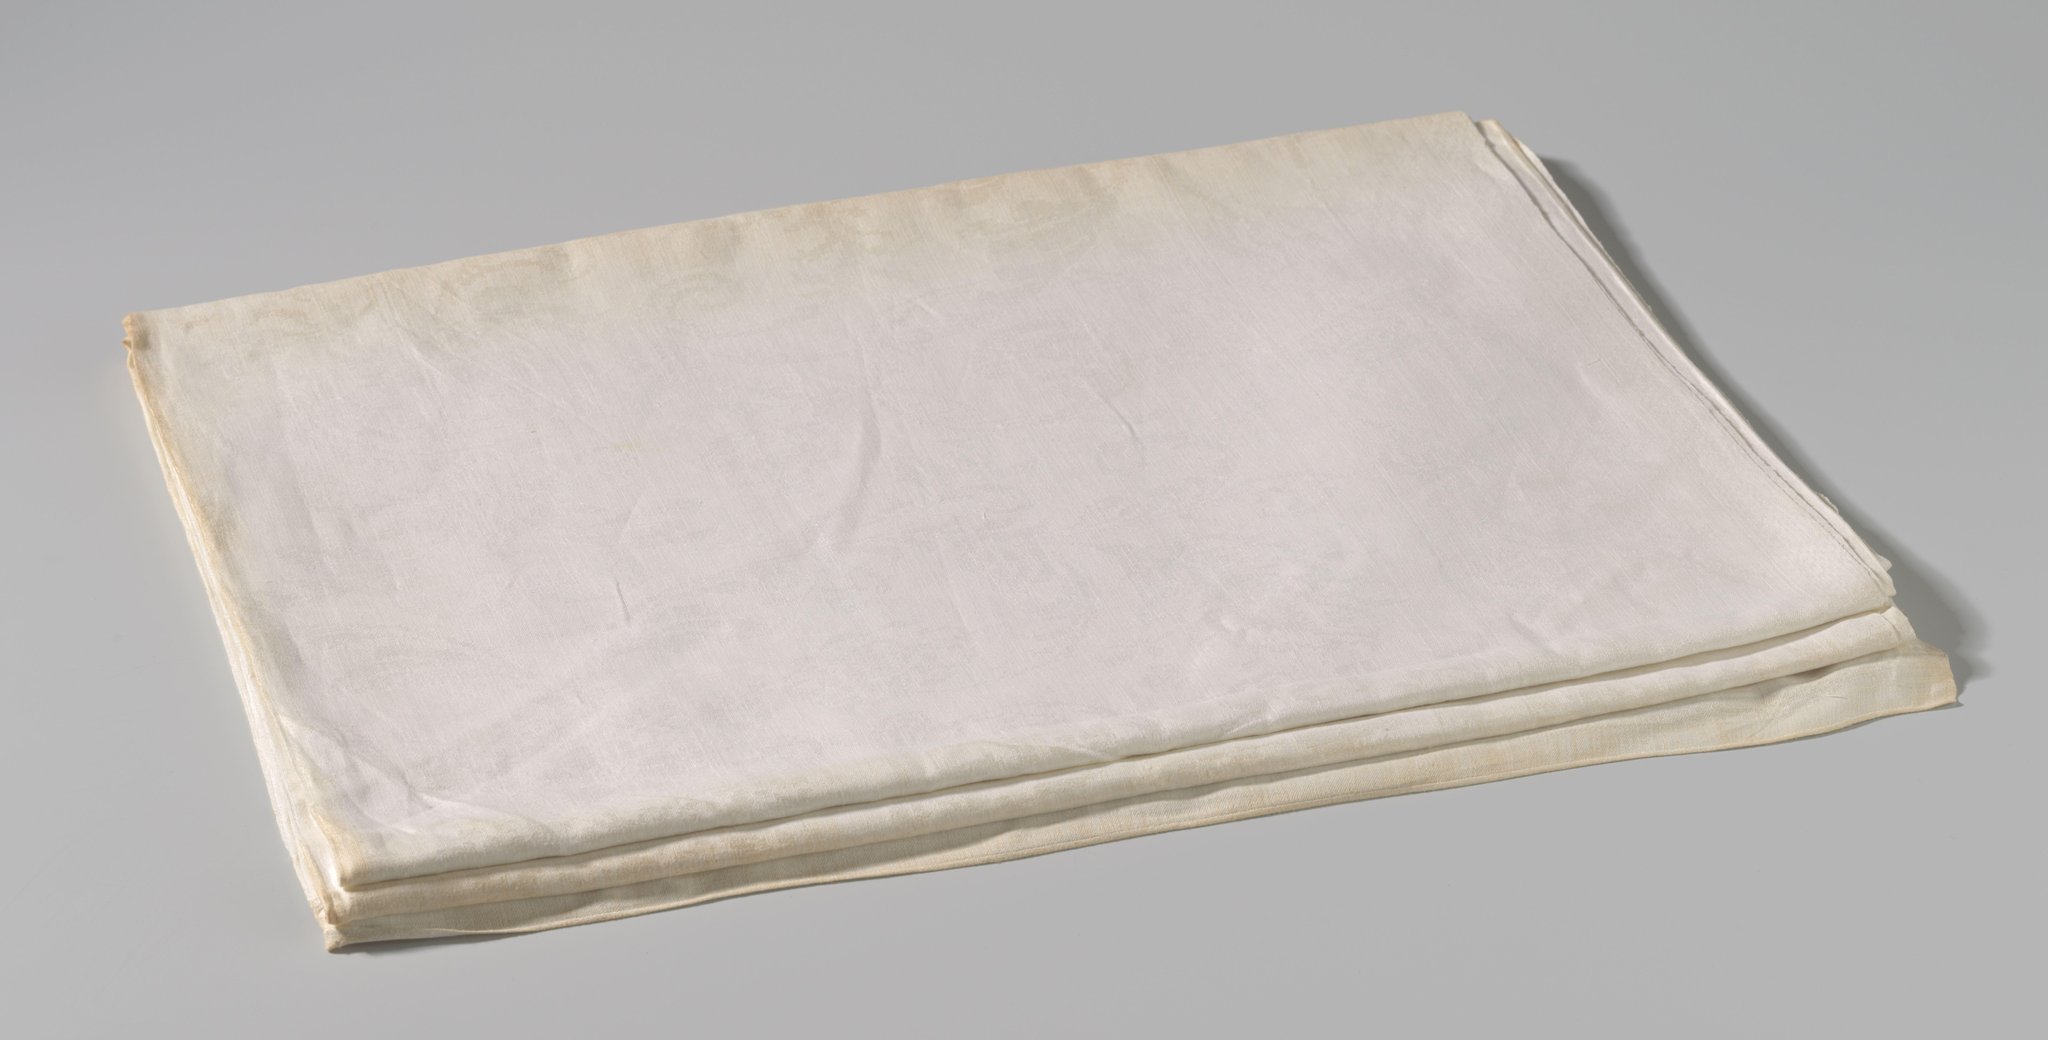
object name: tablecloth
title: Tafellaken met het wapen van Cornelis Hop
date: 1700-1724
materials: linen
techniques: damask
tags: cornelis hop (ii)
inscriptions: mark: ‘H’, mark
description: Tafellaken van linnendamast met het wapen van Cornelis Hop. Middenveld: symmetrische patroon van veelsoortige voluutranken met op de knooppunten geblokte verdikkingen. Daartussen een liggend ovaal schild met een wapen van Cornelis Hop (1685-1762), ambassadeur aan het hof van koning Lodewijk XV van Frankrijk: gevierendeeld, 1 en 4 kopvogel staande op bol (de vogel van 1 omgewend, die van 4 omziend); 2 en drie twee afgewende vleugels. Hartschild gedeeld: 1 een dwarsbalk, 2 rechts een vijfpuntige ster, links een gewende wassenaar. Het schild gedekt met vijfbladerige kroon. Schildhouders: rechts een afgewende adelaar, links een afgewende leeuw. Randen: wapentrofeeën. Hoeken: een rondas. Rondom blokkenrand.